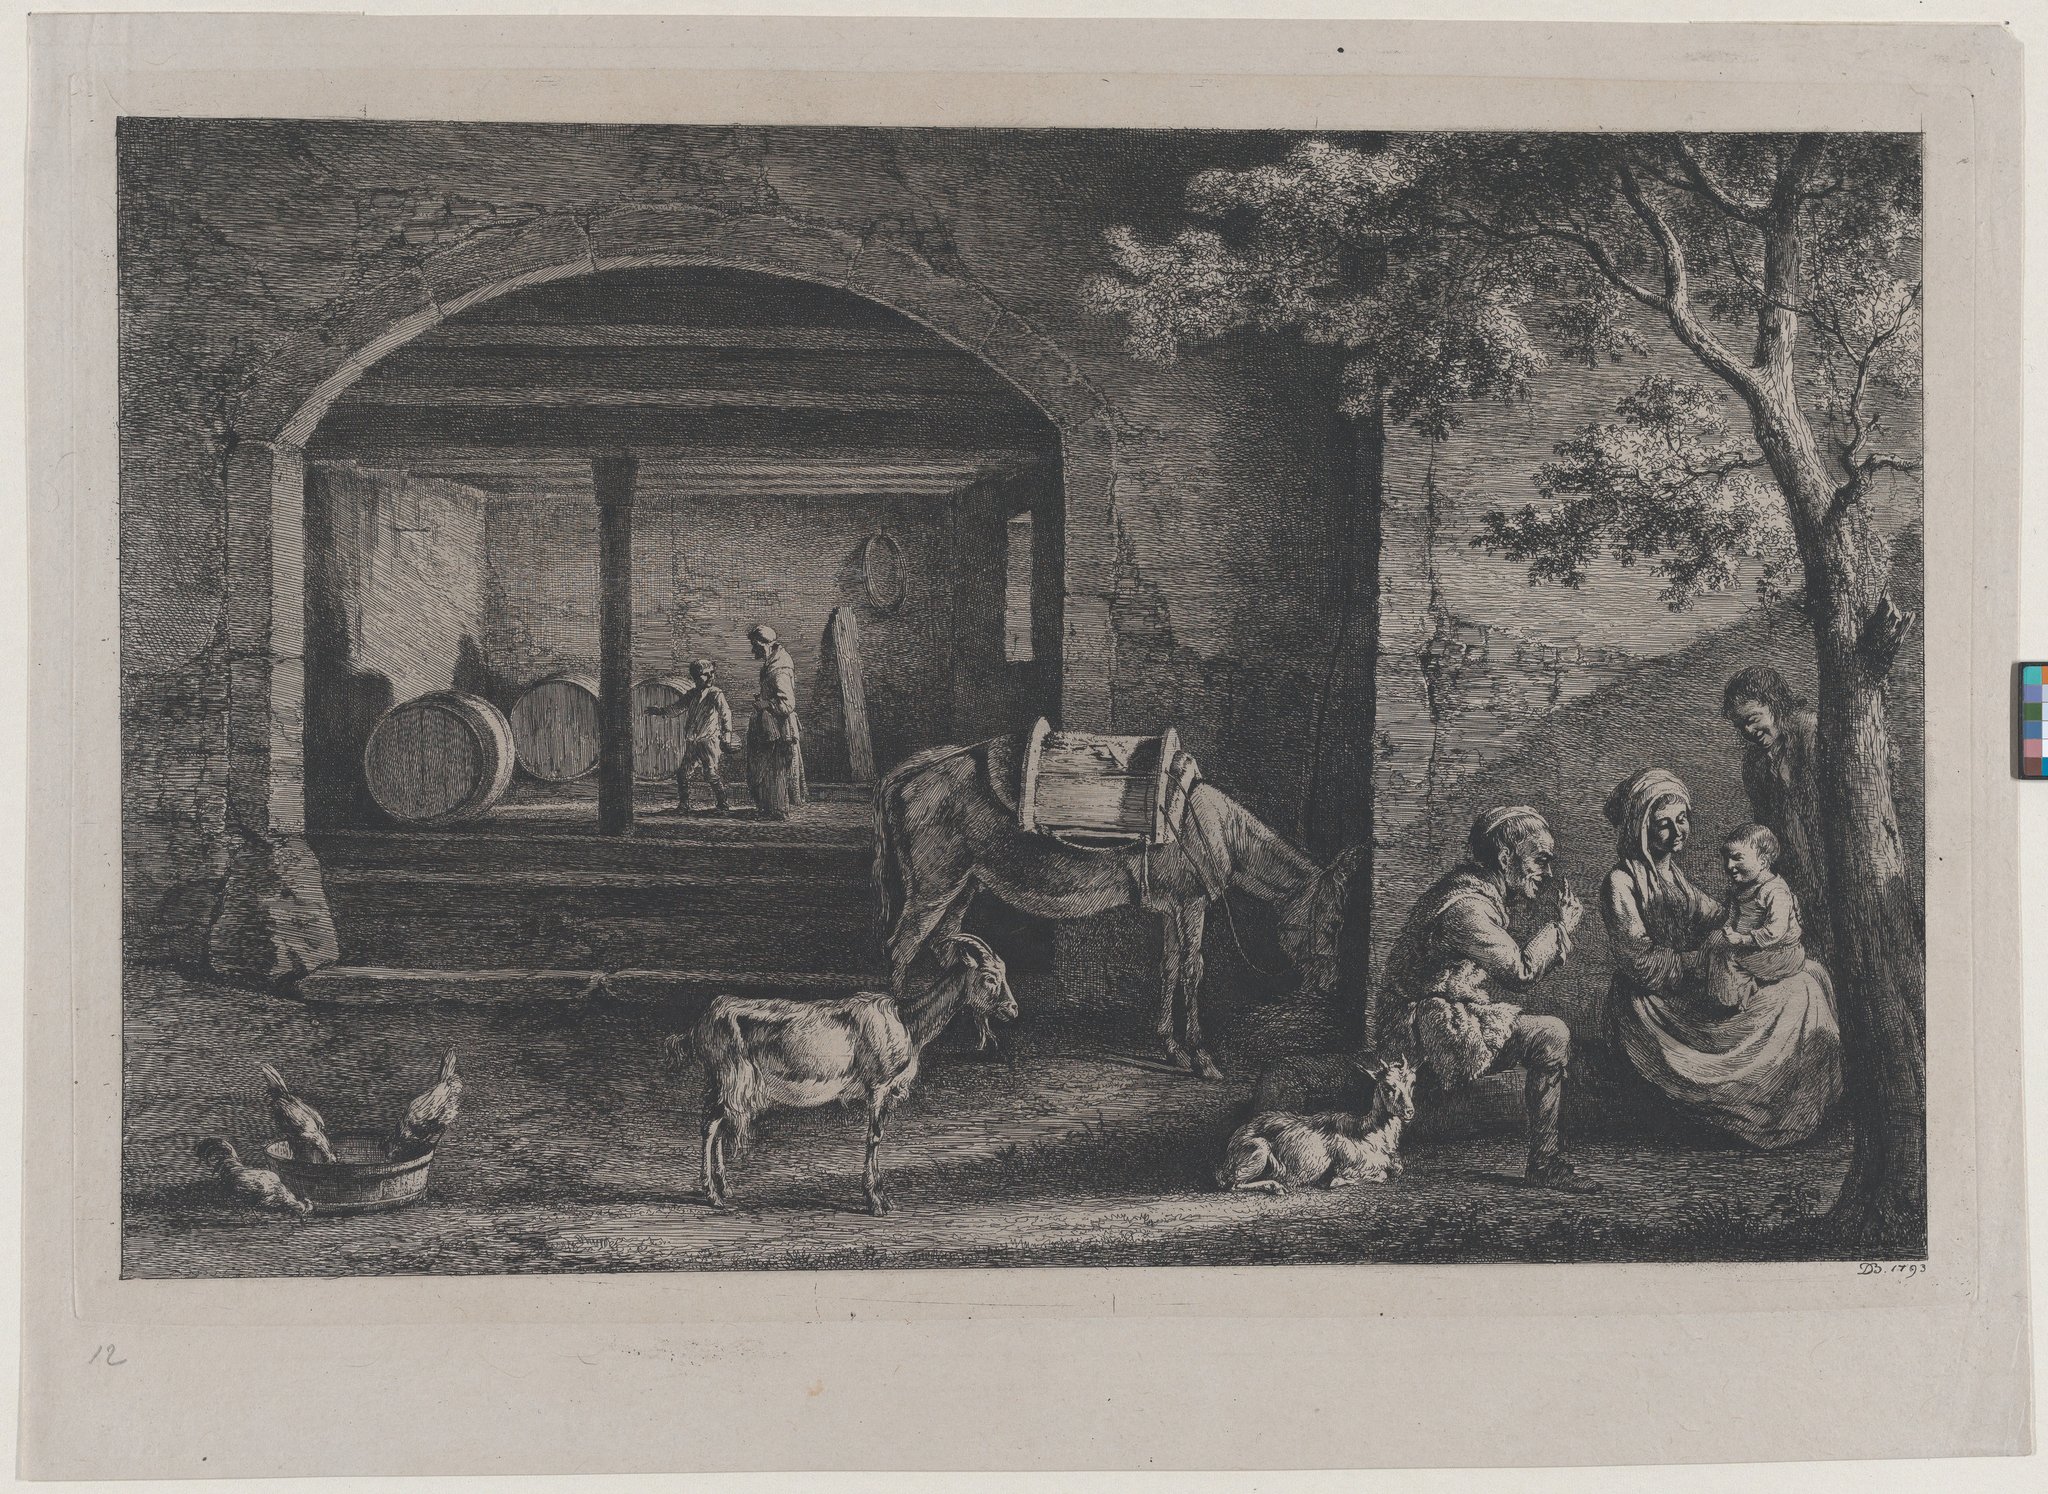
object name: print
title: Interior of a Farm at Saint-Jean-de-Touslas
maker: jean jacques de boissieu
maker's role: artist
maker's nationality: french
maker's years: 1736-1810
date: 1793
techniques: drypoint, etching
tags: farms,men,women,goats,horses